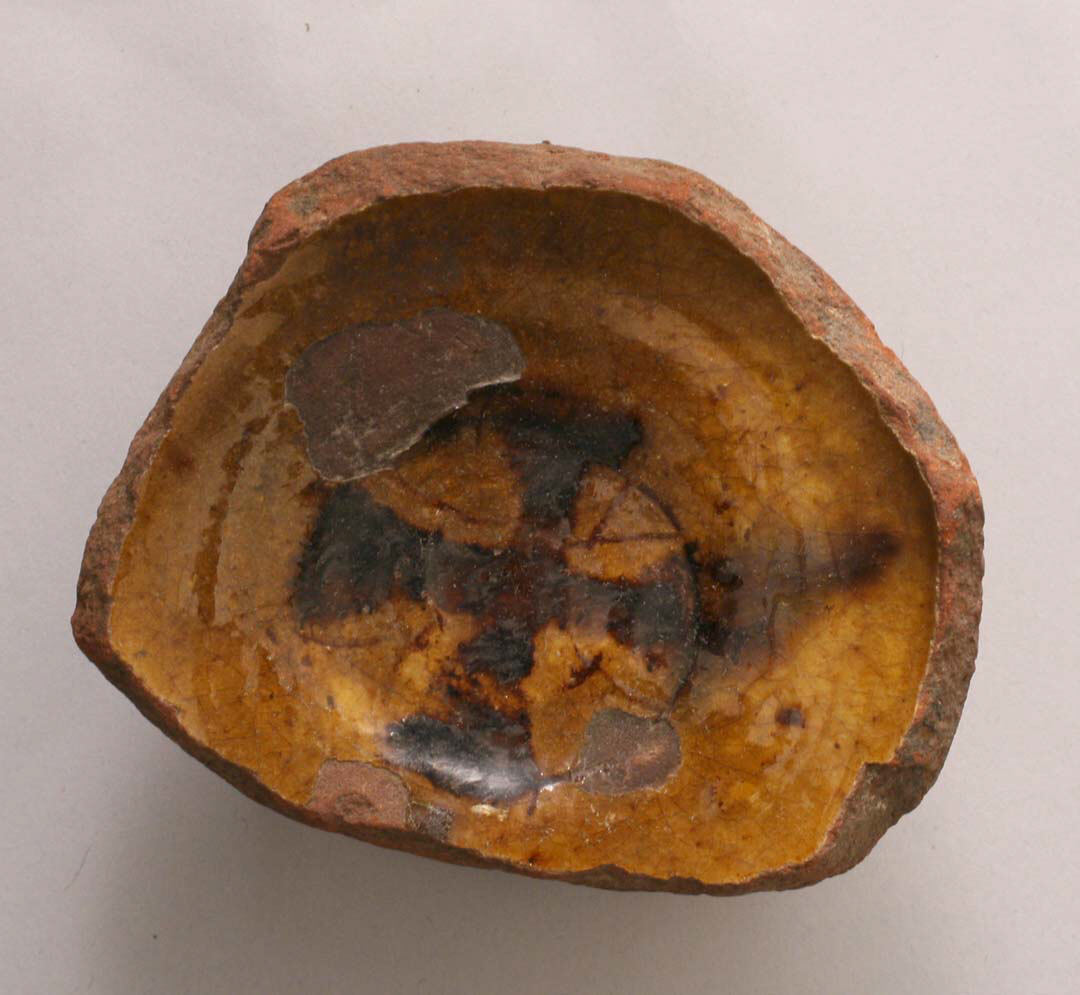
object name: ceramic fragment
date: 1301-1500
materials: earthenware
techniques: glazing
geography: egypt